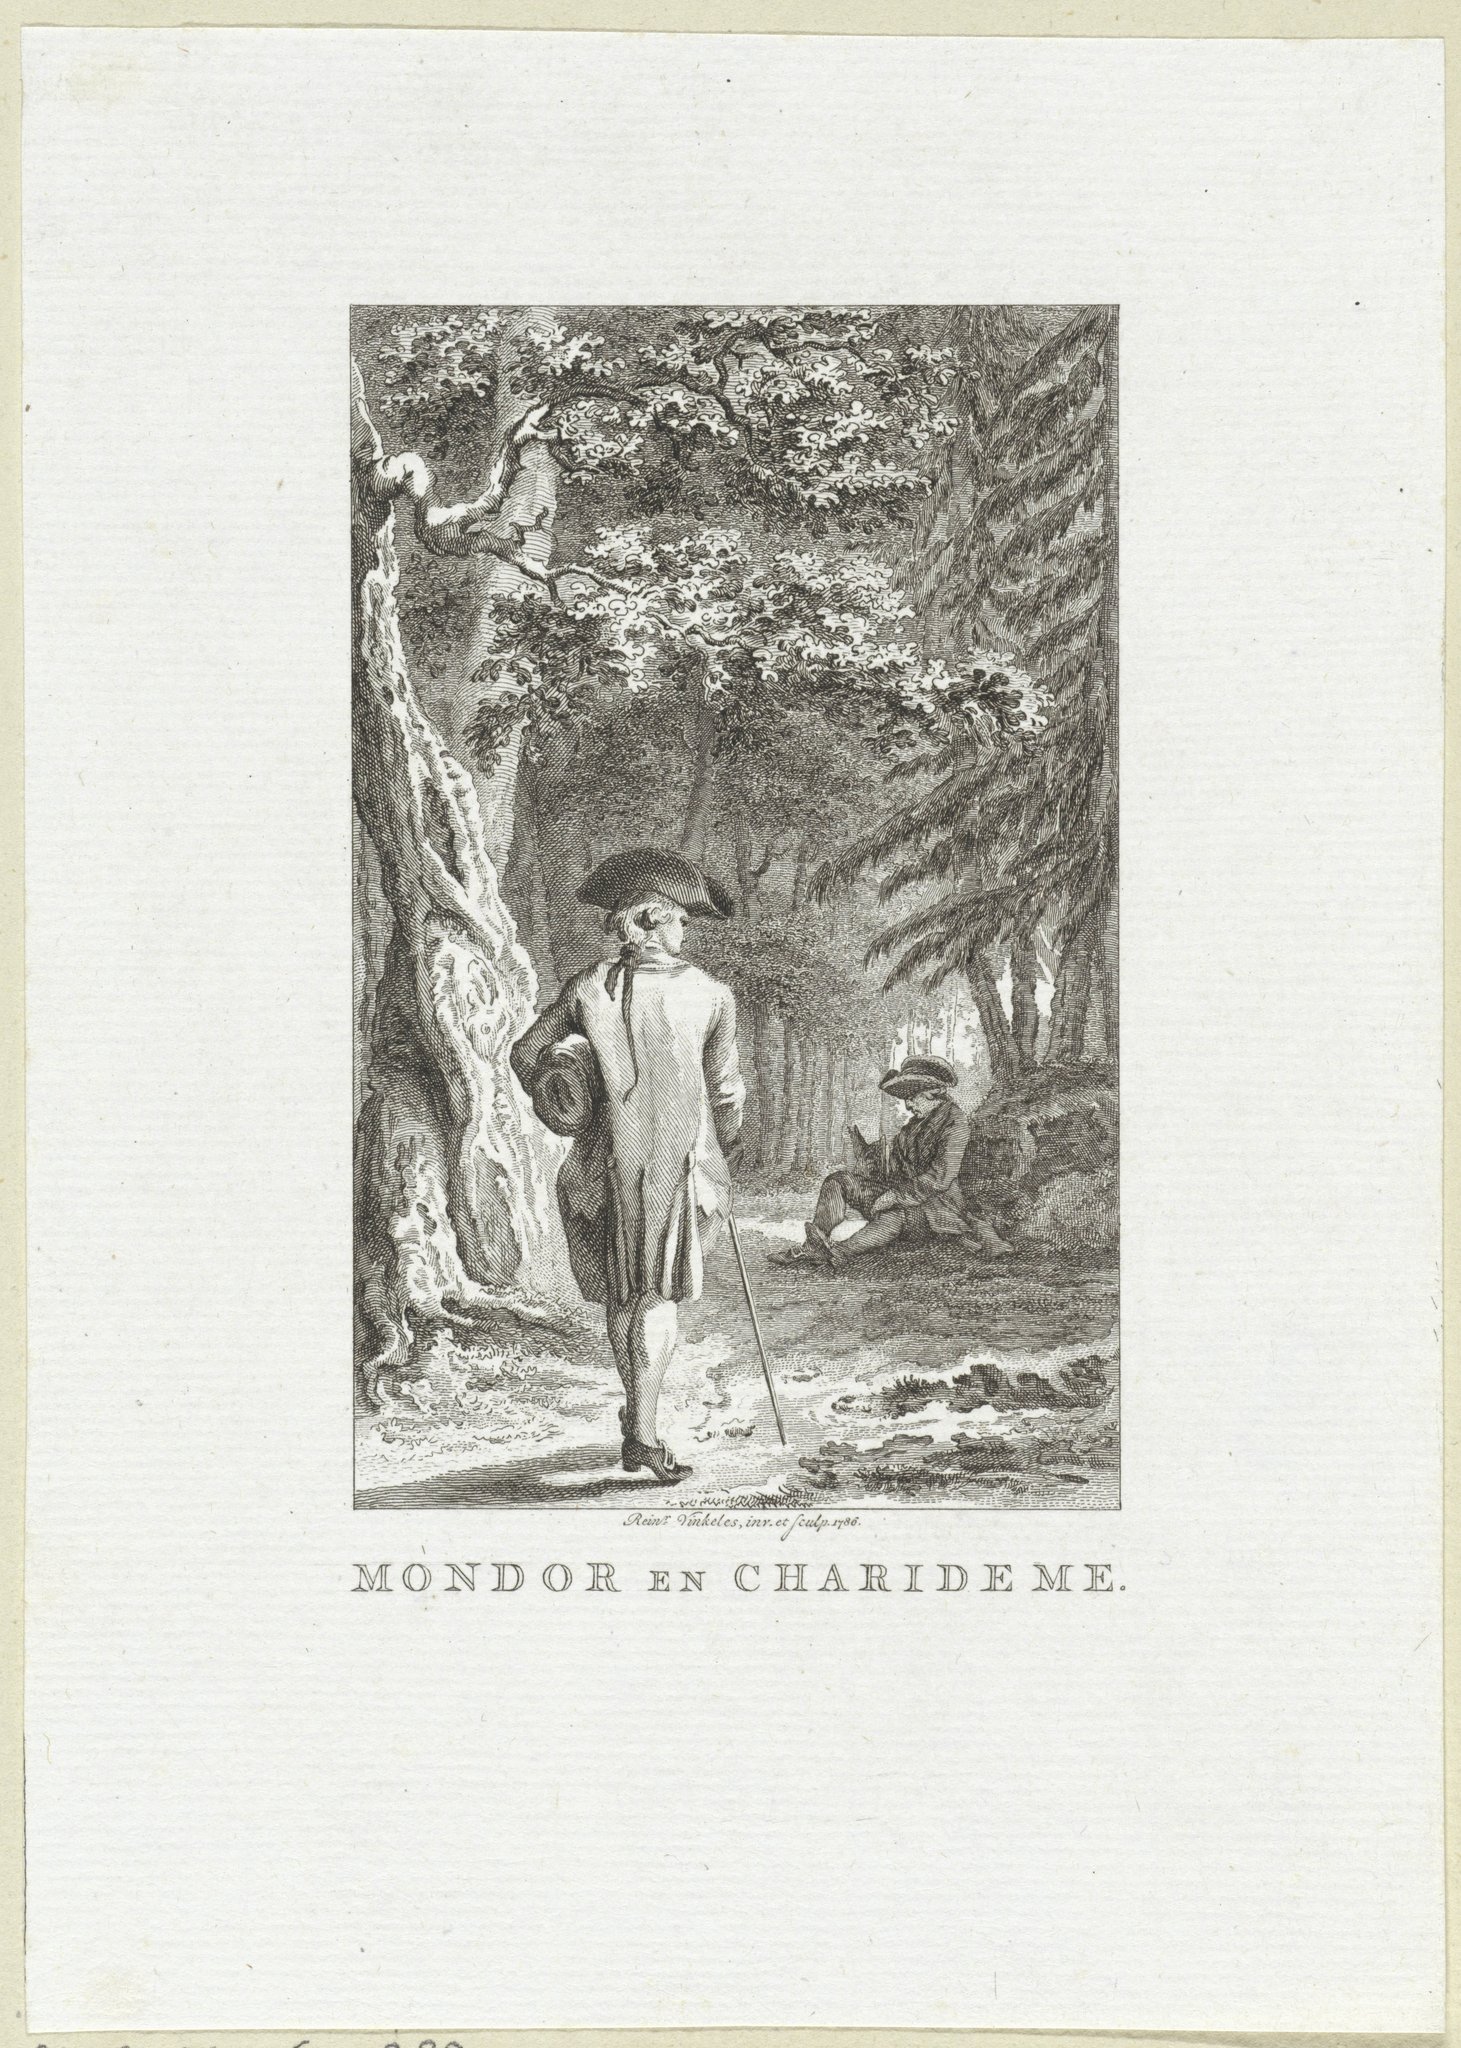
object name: print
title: Lezende man en een wandelaar op een bospad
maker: reinier vinkeles (i)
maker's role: draughtsman, print maker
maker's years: 1741-1816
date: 1786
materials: paper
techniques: engraving, etching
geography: amsterdam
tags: reading, walking-stick, staff, forest path or lane, 'en route', traveller under way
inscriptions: collector's mark: Lugt 240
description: Deze prent is ook gebruikt als illustratie bij het verhaal 'Mondor en Charideme' voor: Mercier, L.S. Zedelijke verhaalen, deel 10. Amsterdam: A. Mens Jansz., 1786.